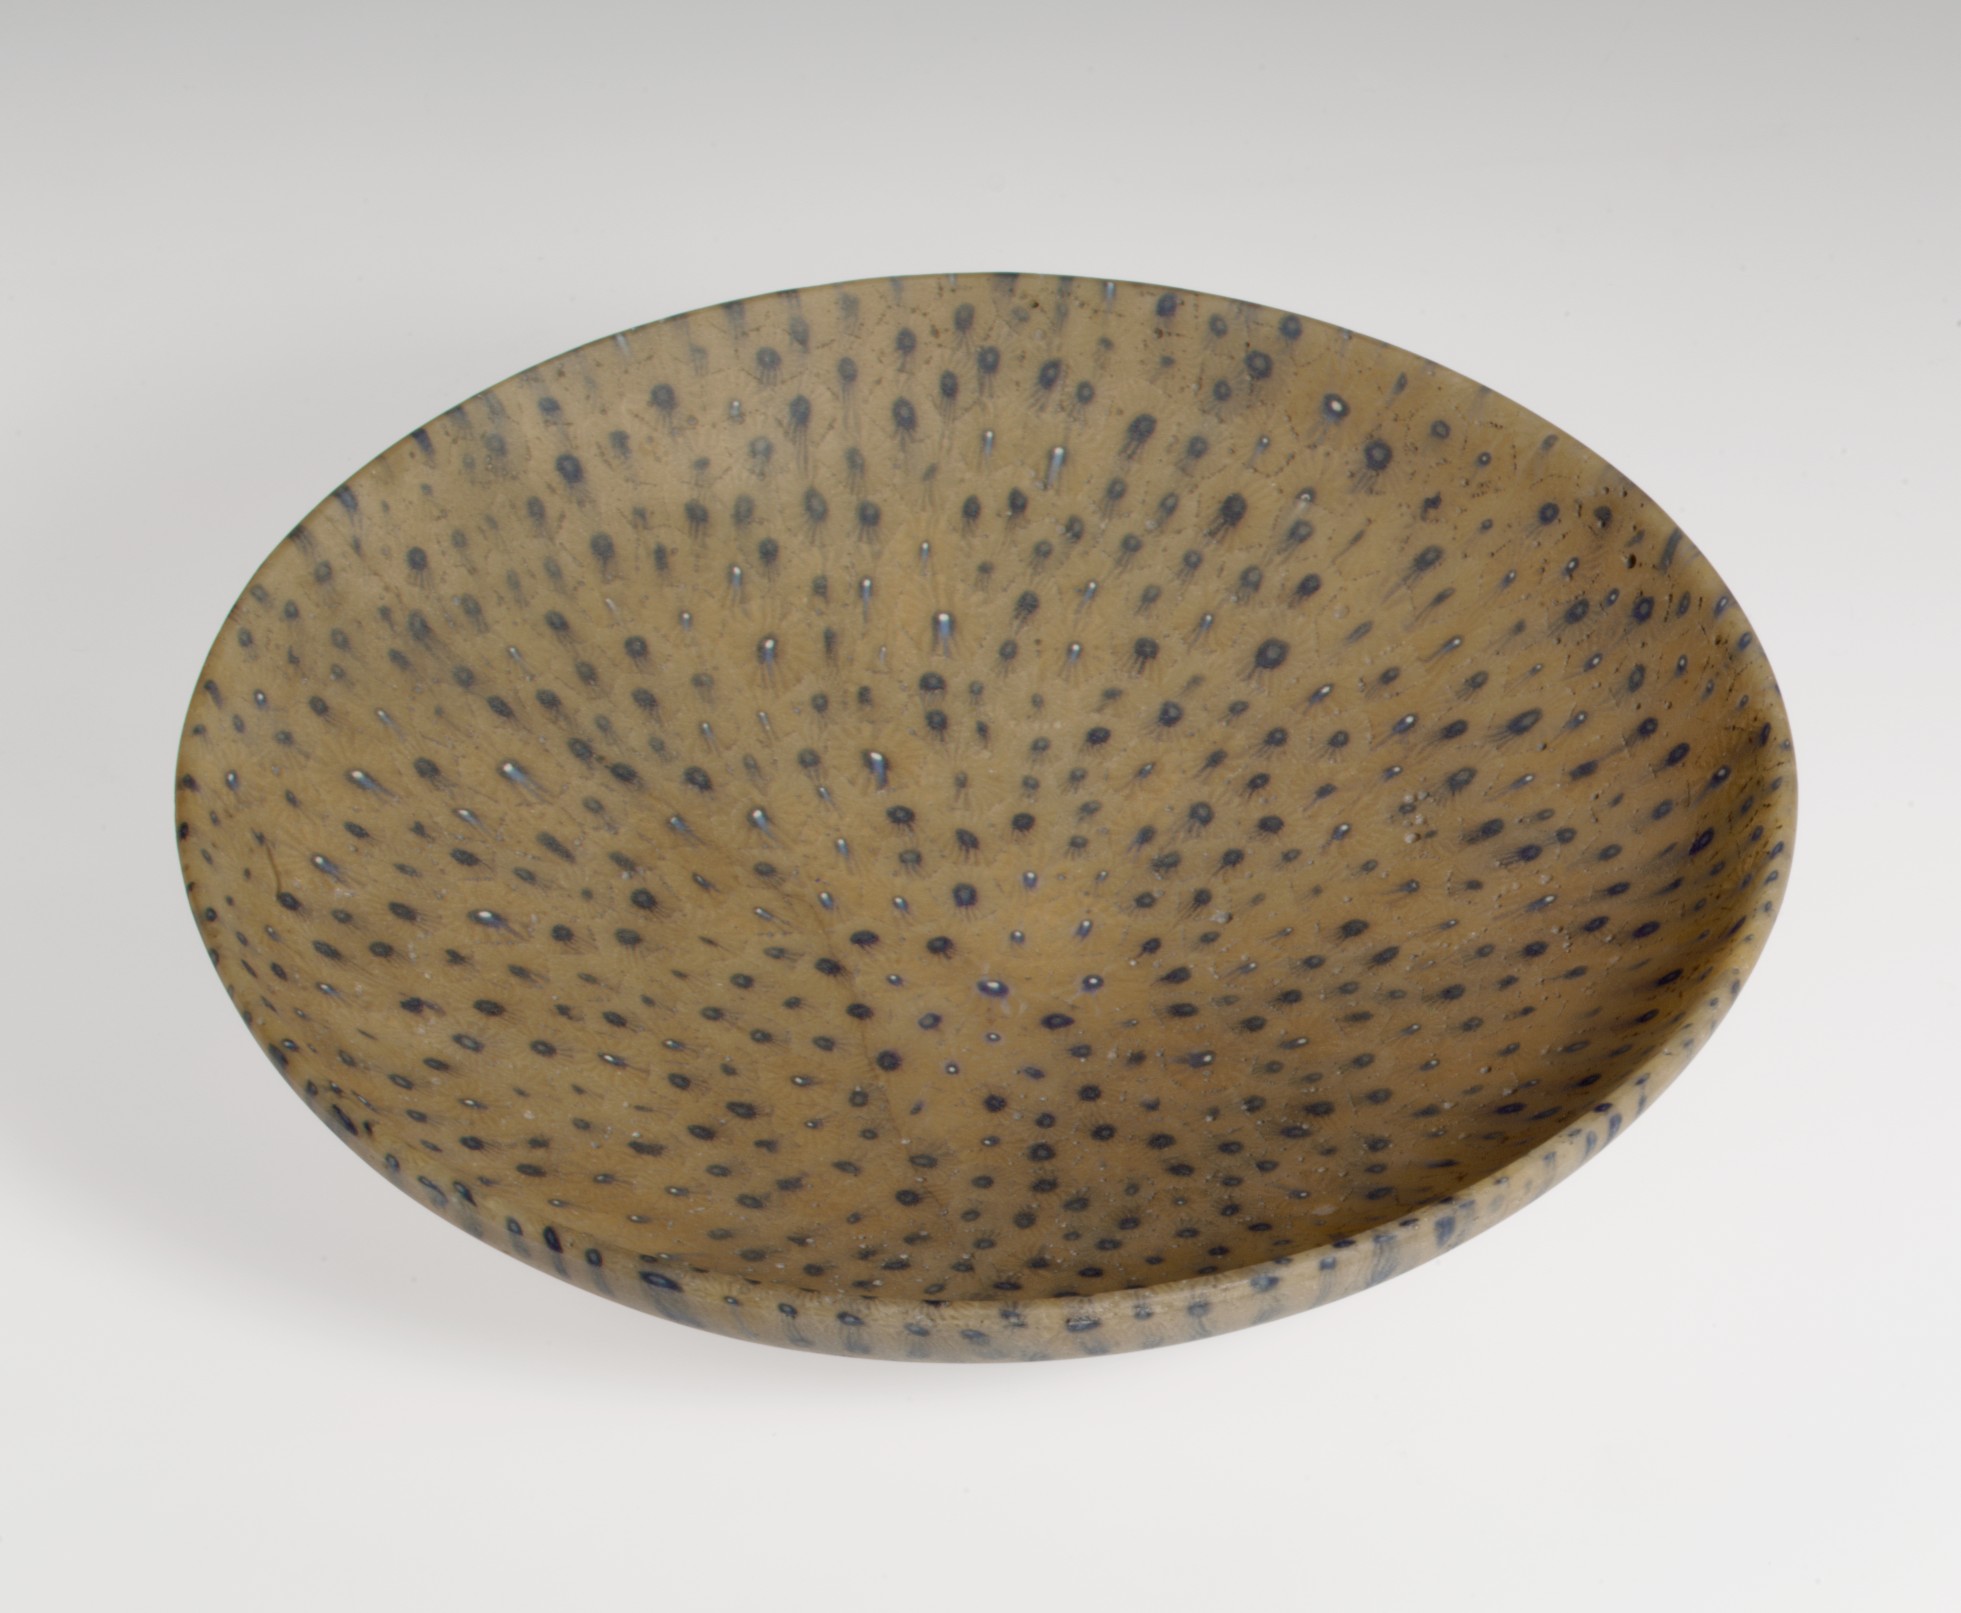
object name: dish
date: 1880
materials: glass